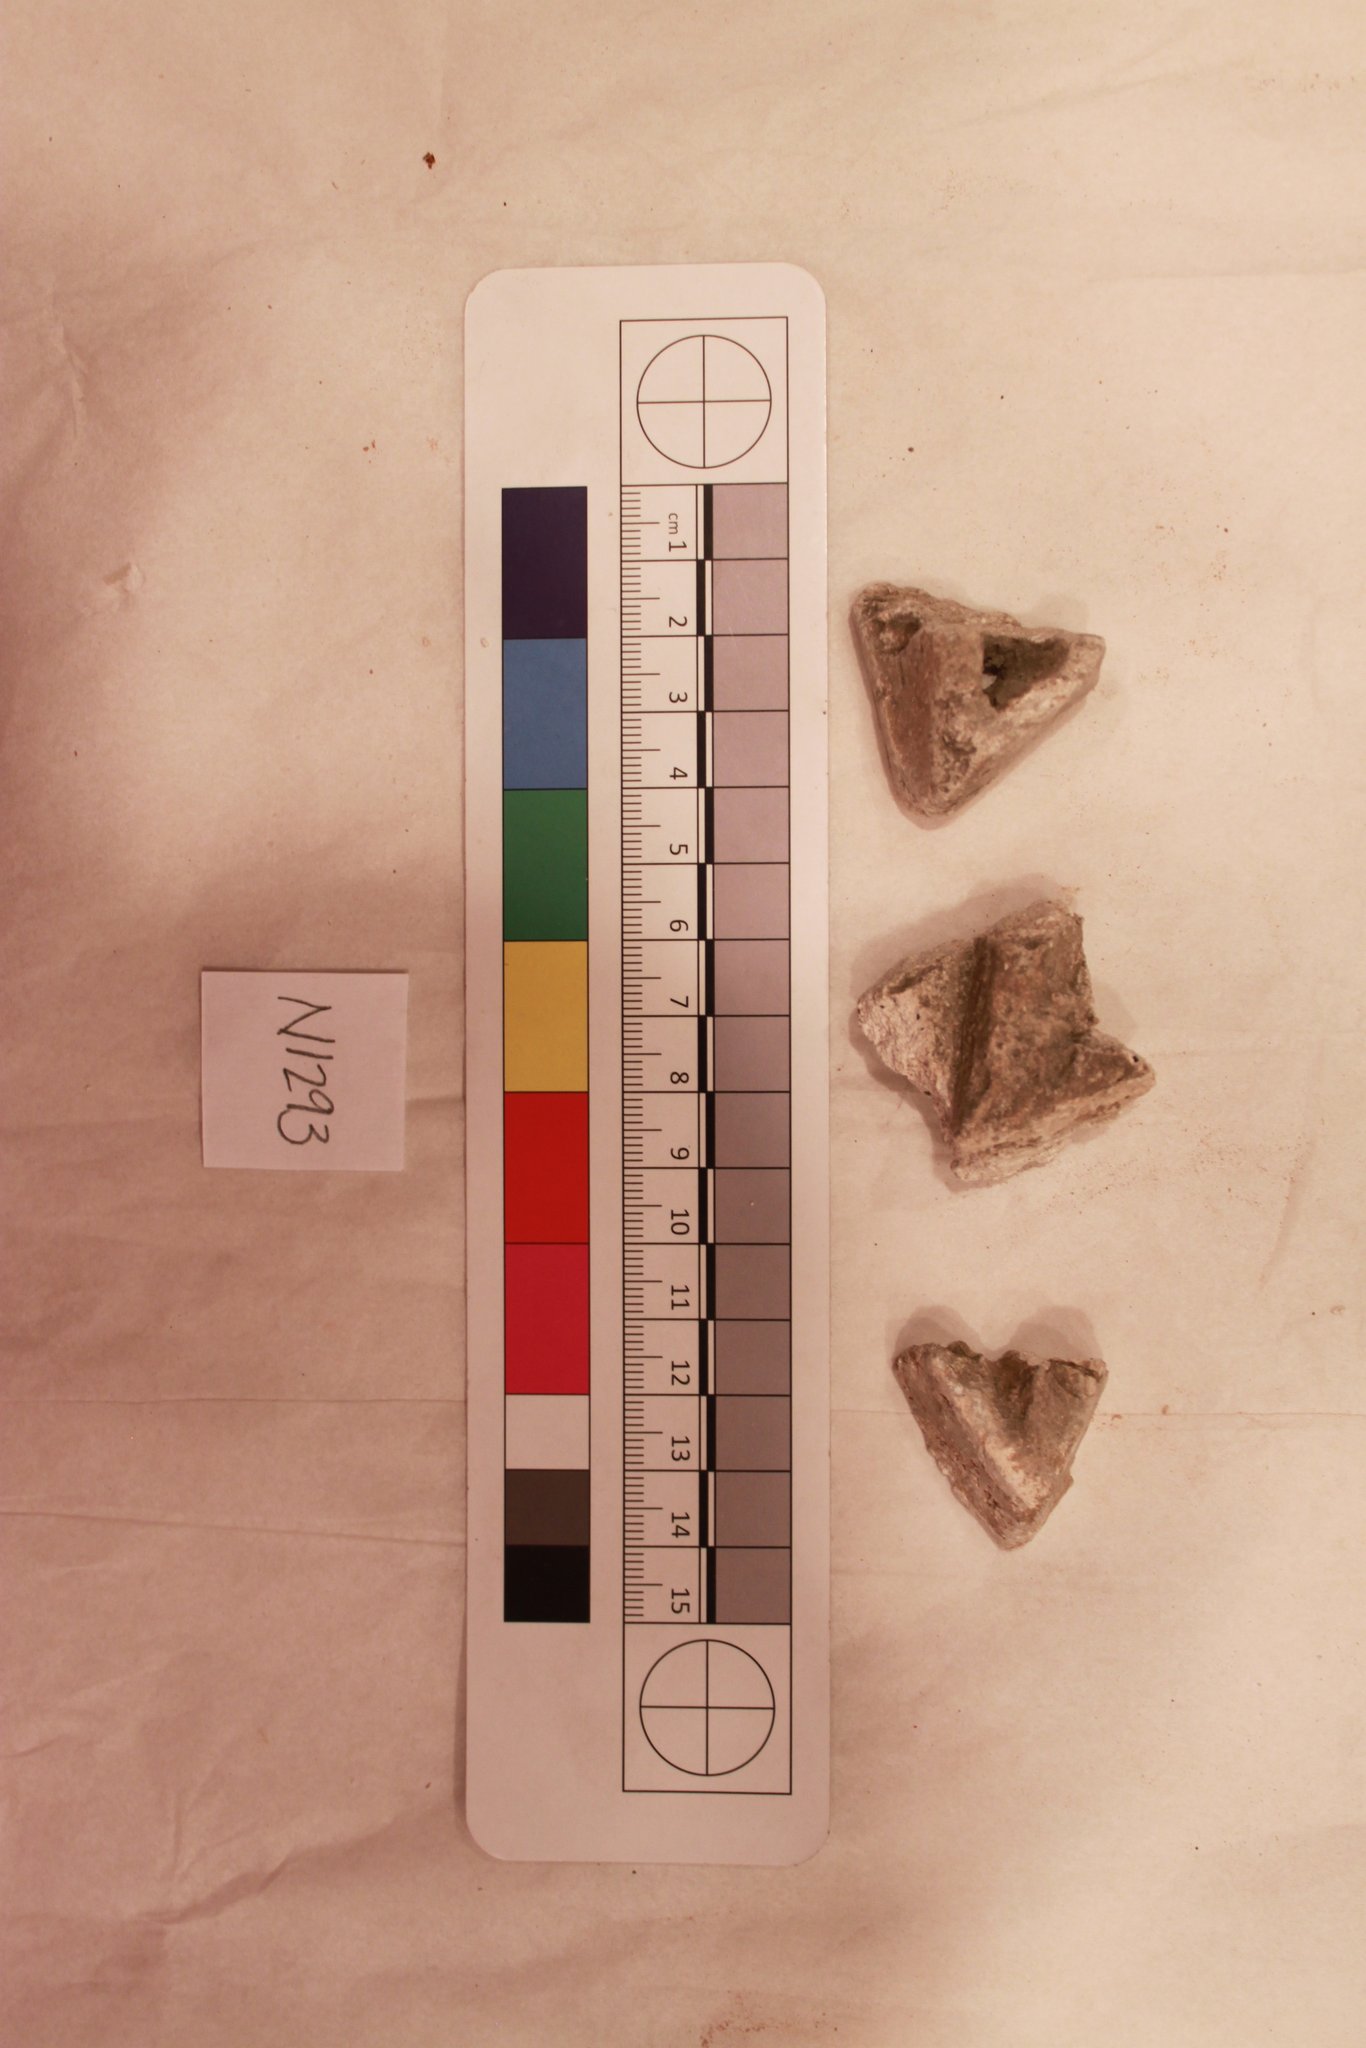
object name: fragment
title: Stucco Fragment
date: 701-1200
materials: plaster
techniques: carving, painting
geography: iran